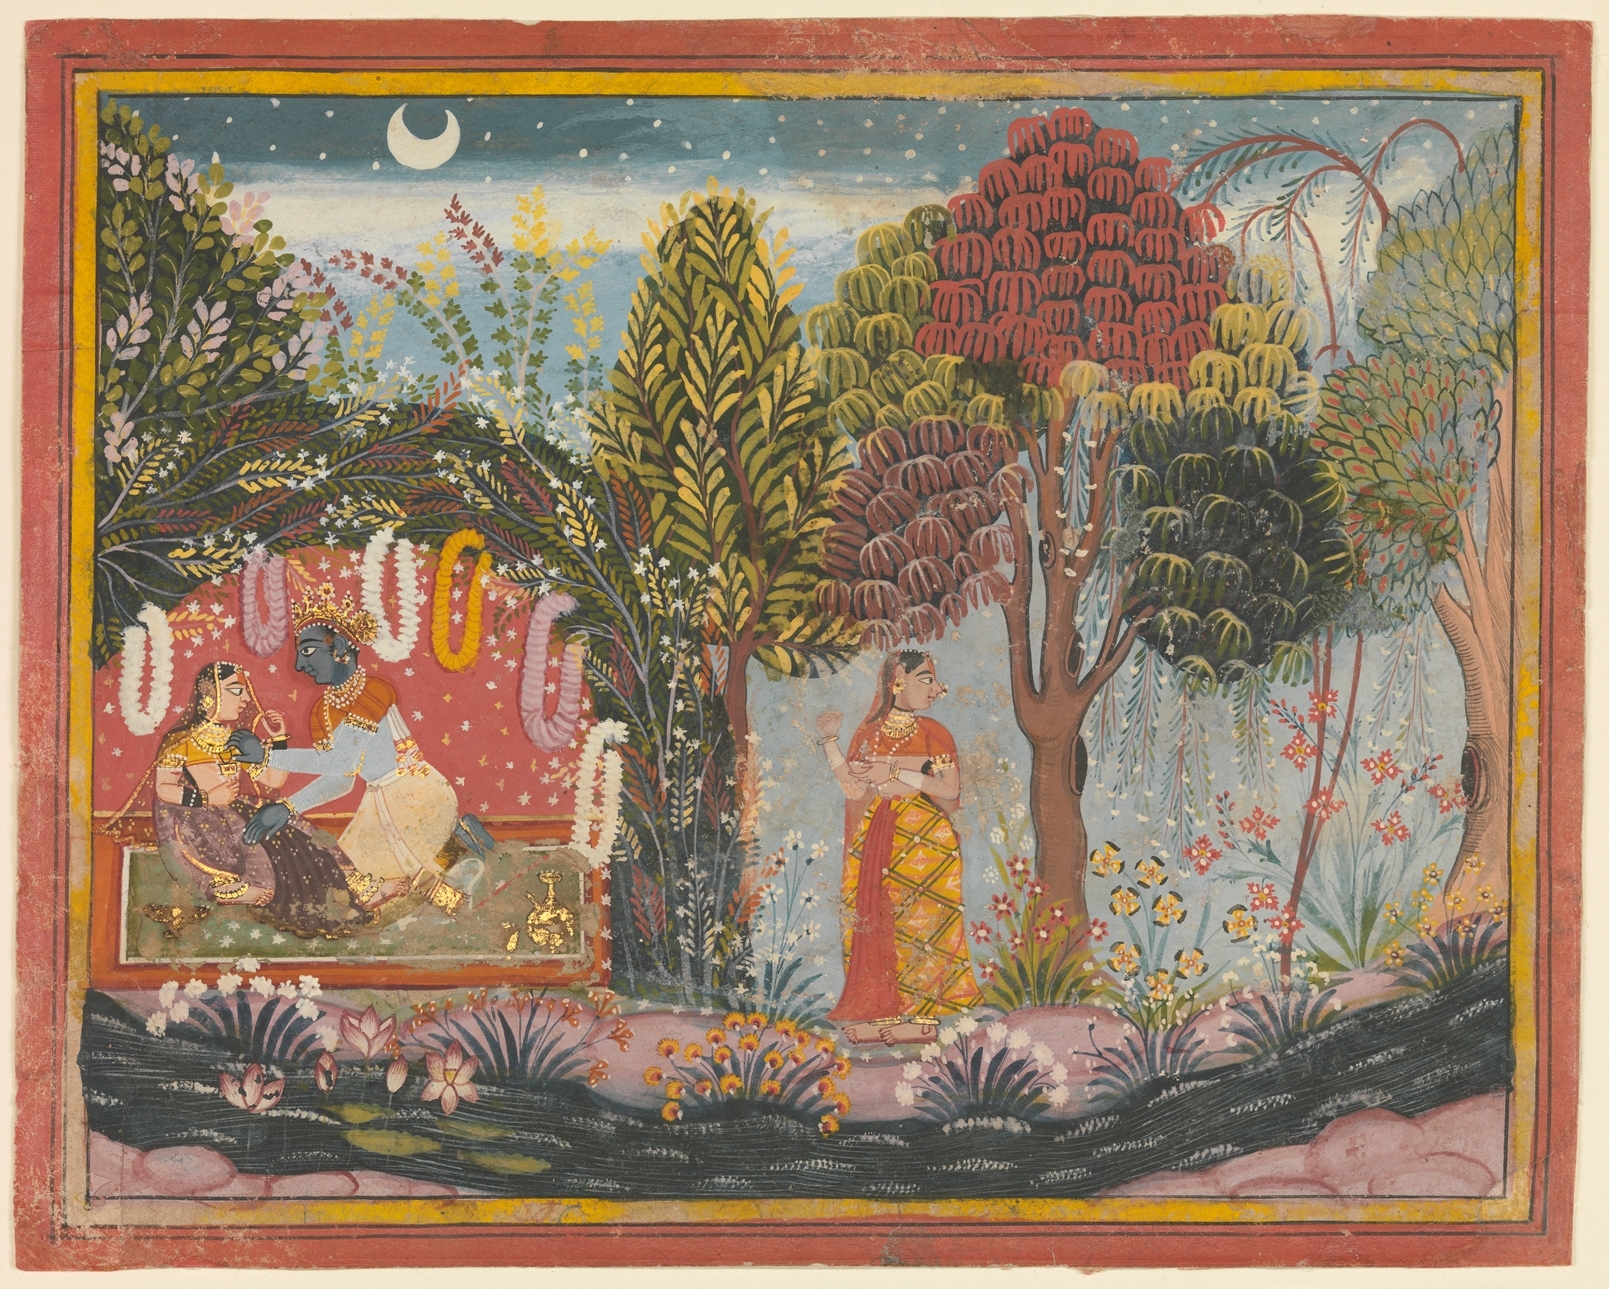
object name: folio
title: Krishna and Radha in a Bower: Page From a Dispersed Gita Govinda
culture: mewar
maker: sahibdin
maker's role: artist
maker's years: 1618-1665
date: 1665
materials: ink, paper, watercolor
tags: women,trees,krishna,radha